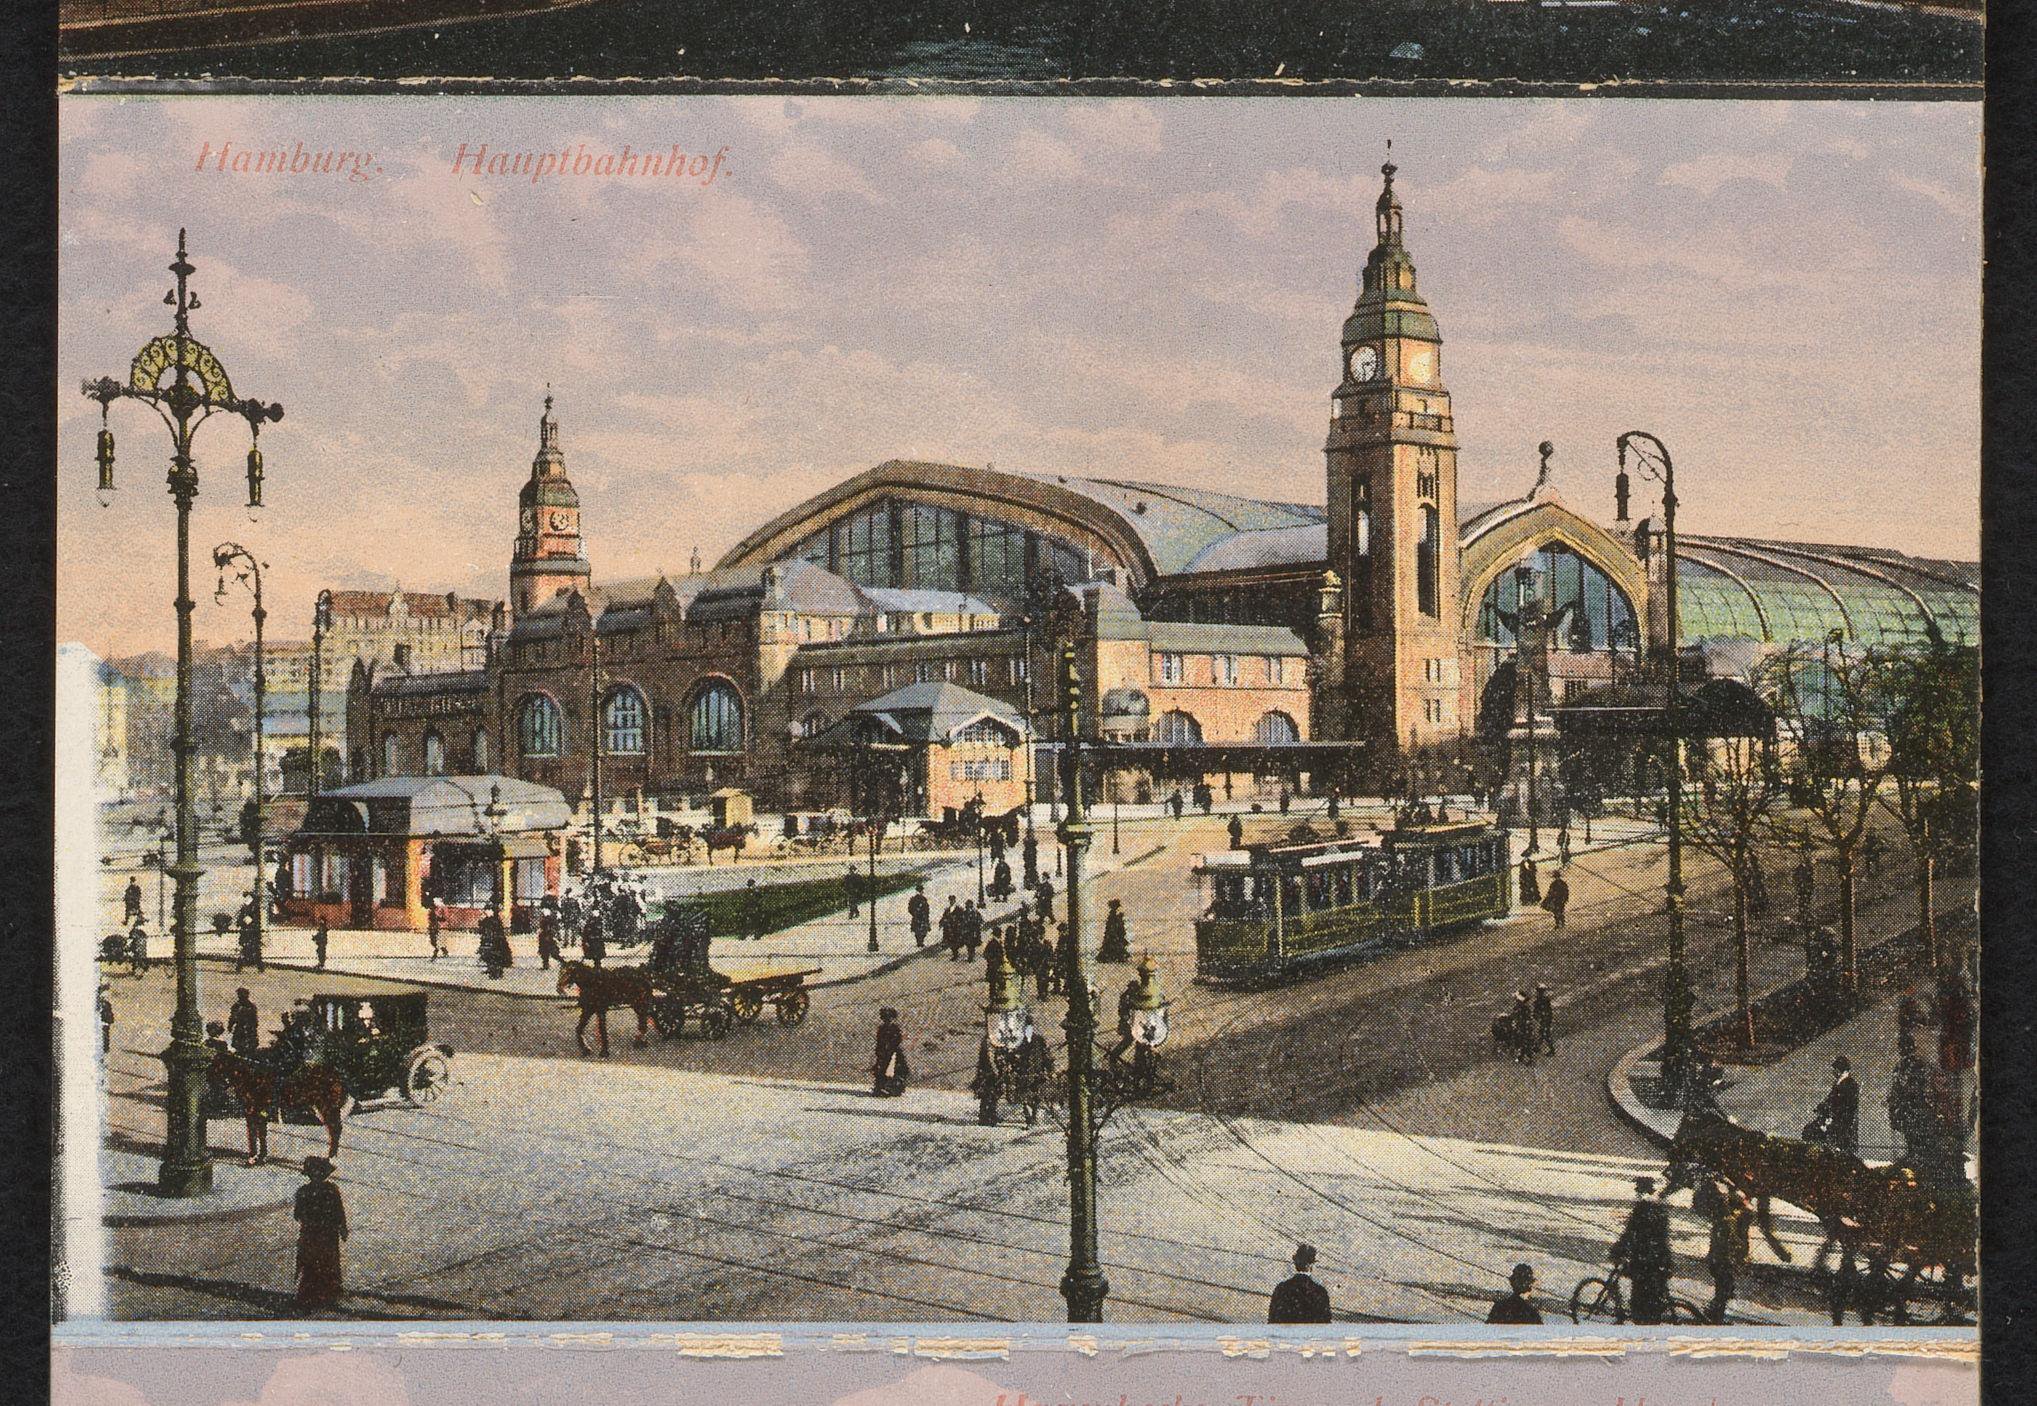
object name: photomechanical print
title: Hamburg. Hauptbahnhof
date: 1905-1930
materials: cardboard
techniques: lithograph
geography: hamburg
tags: station; shelter (railway, tramway)